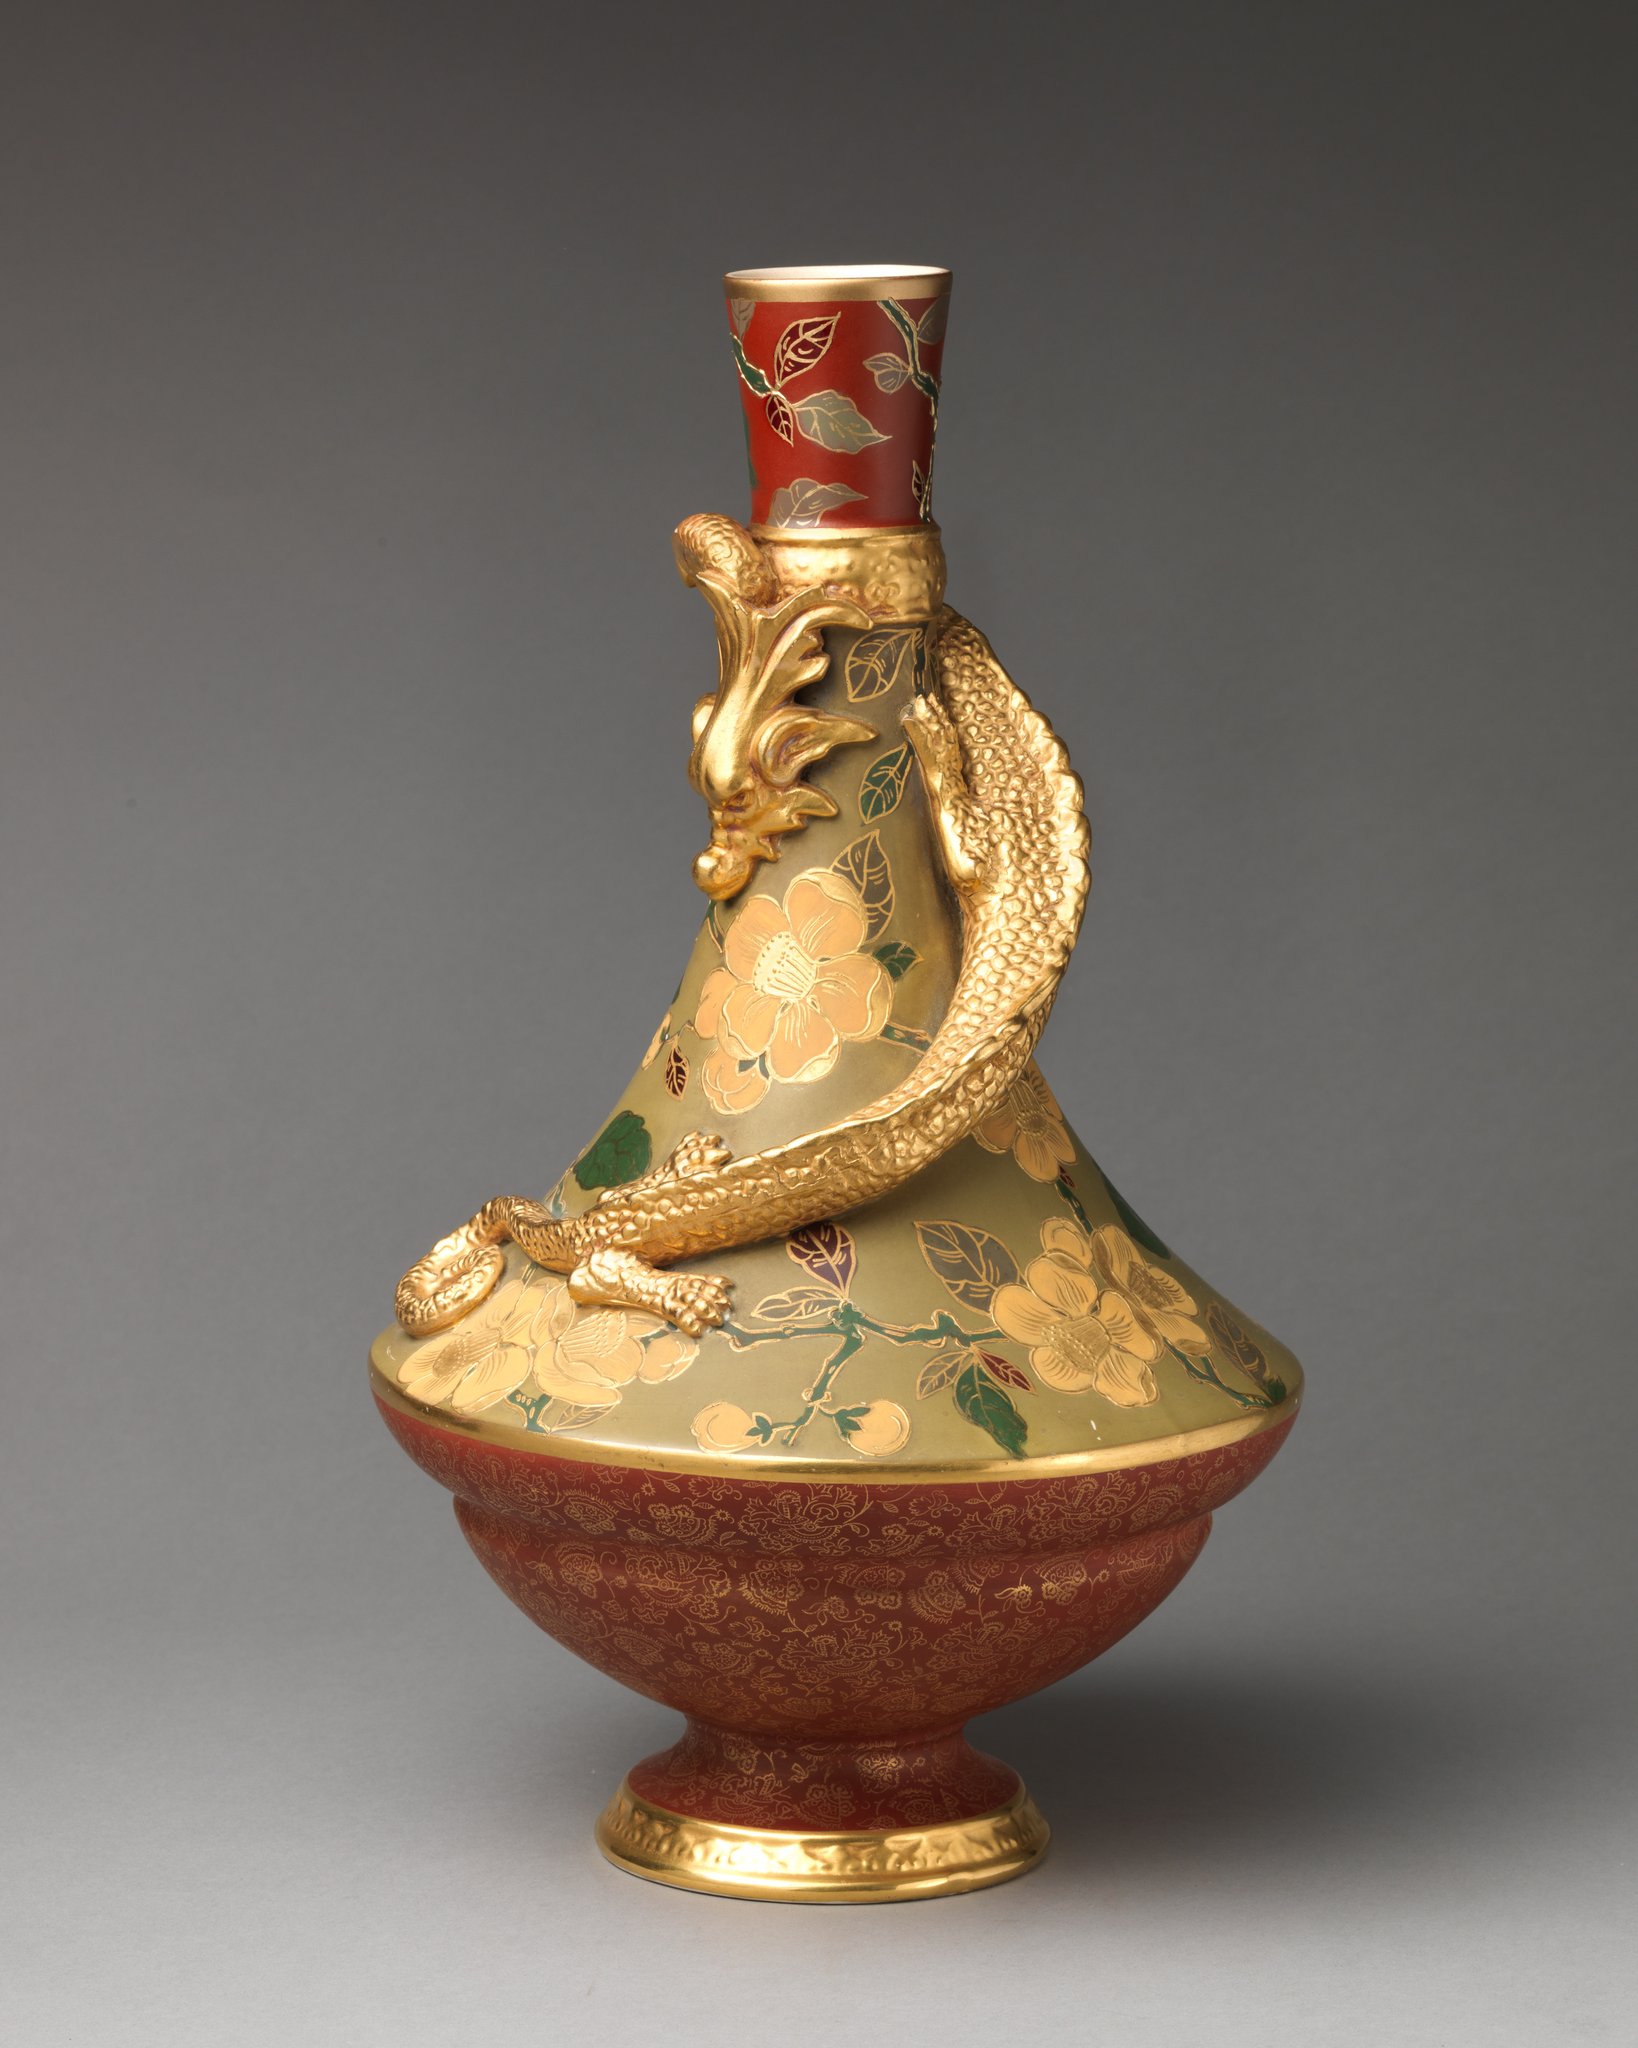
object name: vase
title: Vase with coiled dragon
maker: old hall works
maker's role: maker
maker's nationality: british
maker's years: 1861-1902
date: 1884-1890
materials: earthenware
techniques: gilding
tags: dragons